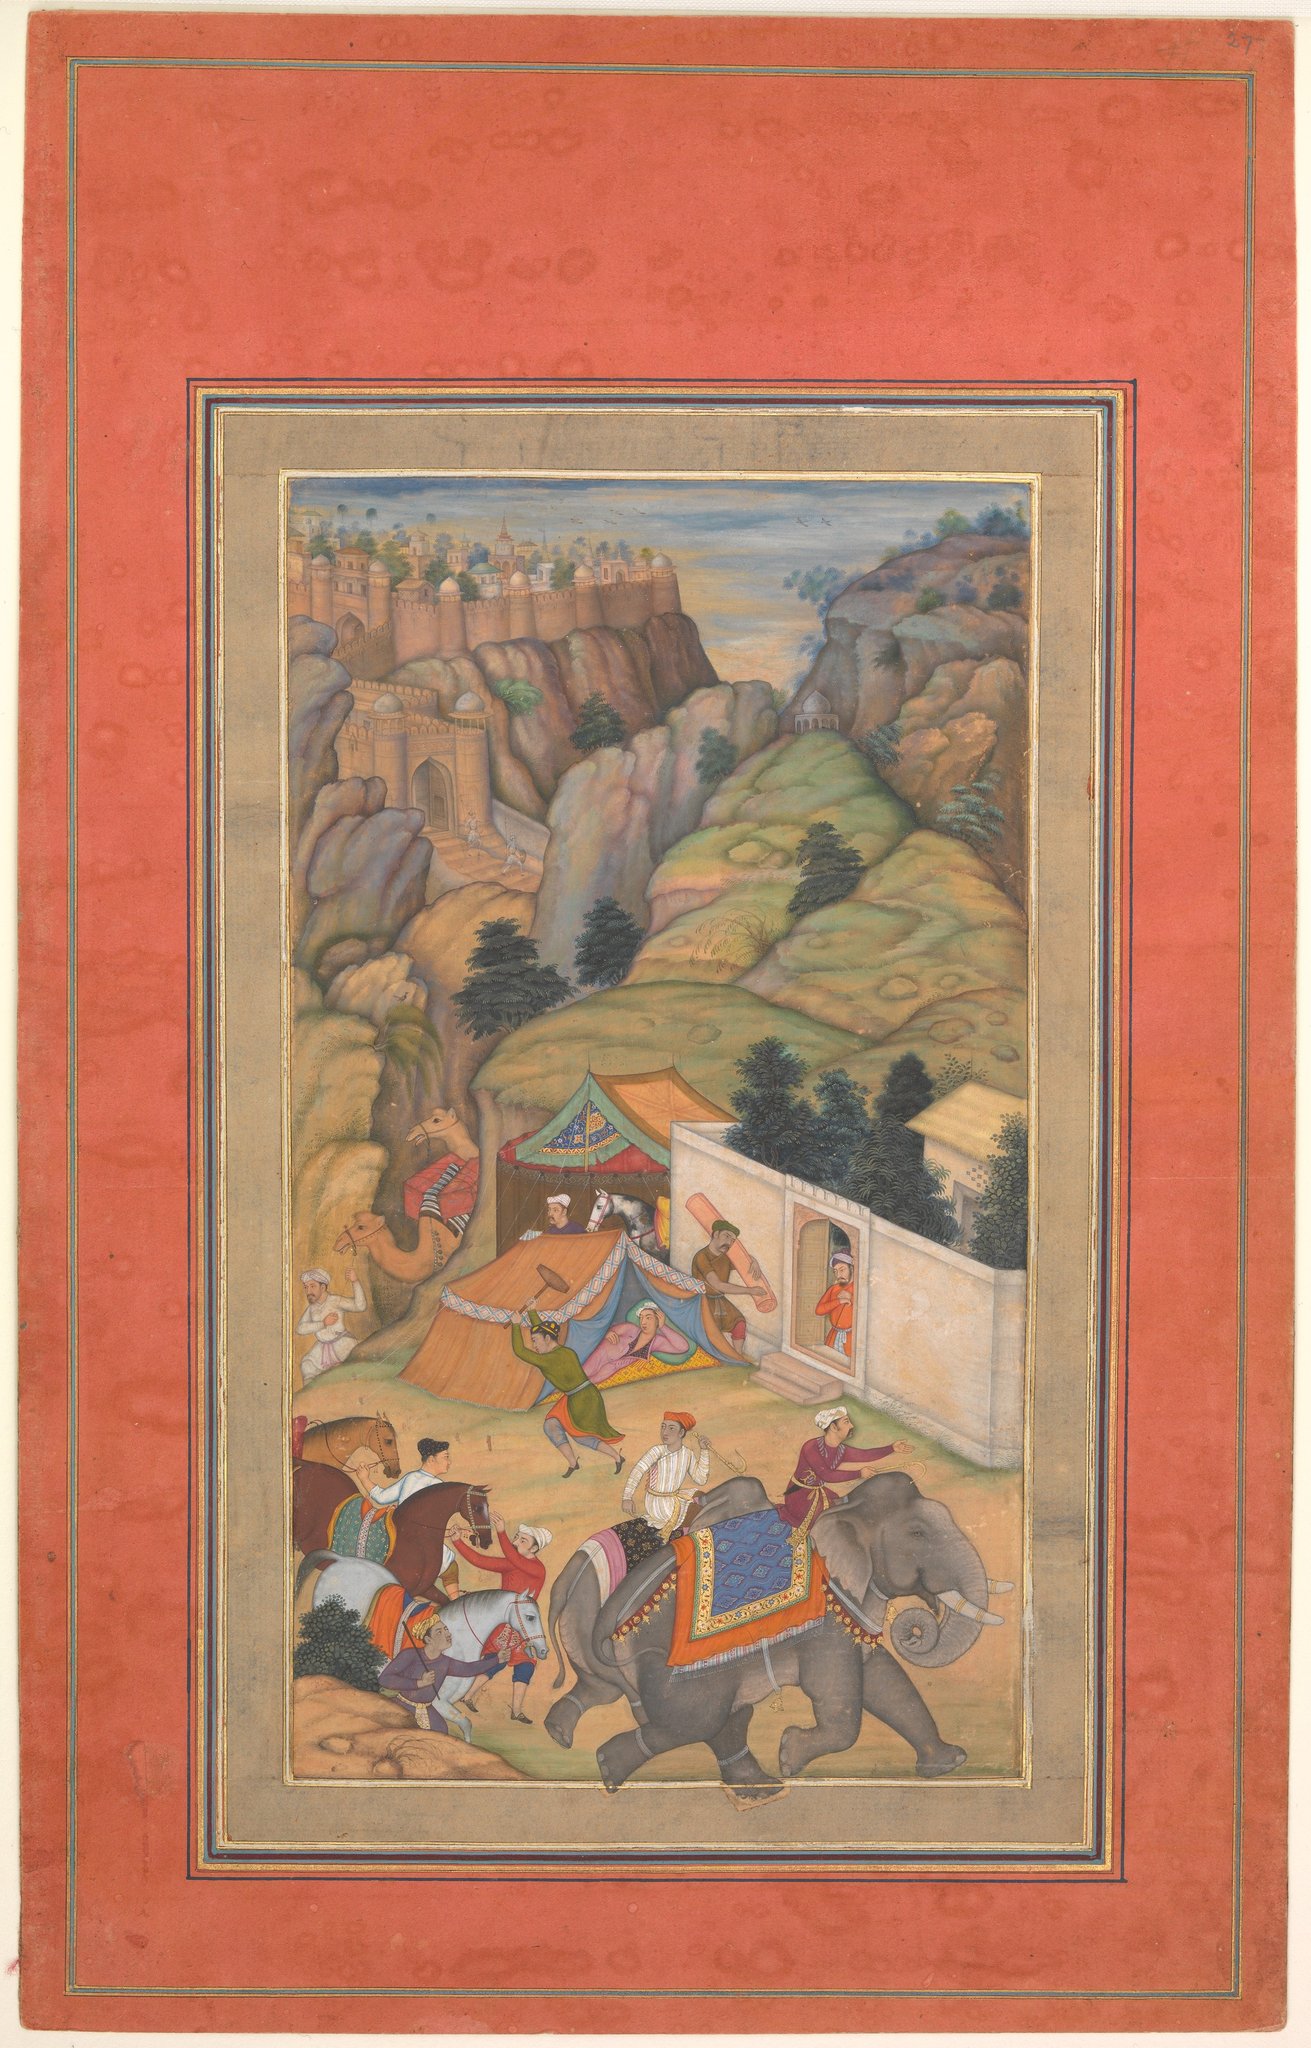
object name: illustrated album leaf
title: "Camp Being Prepared in the Hills", Folio from a Manuscript of the Akbarnama. Folio from the Davis Album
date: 1601-1700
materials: gold, ink, paper, watercolor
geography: india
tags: tents,men,elephants,horses,hills